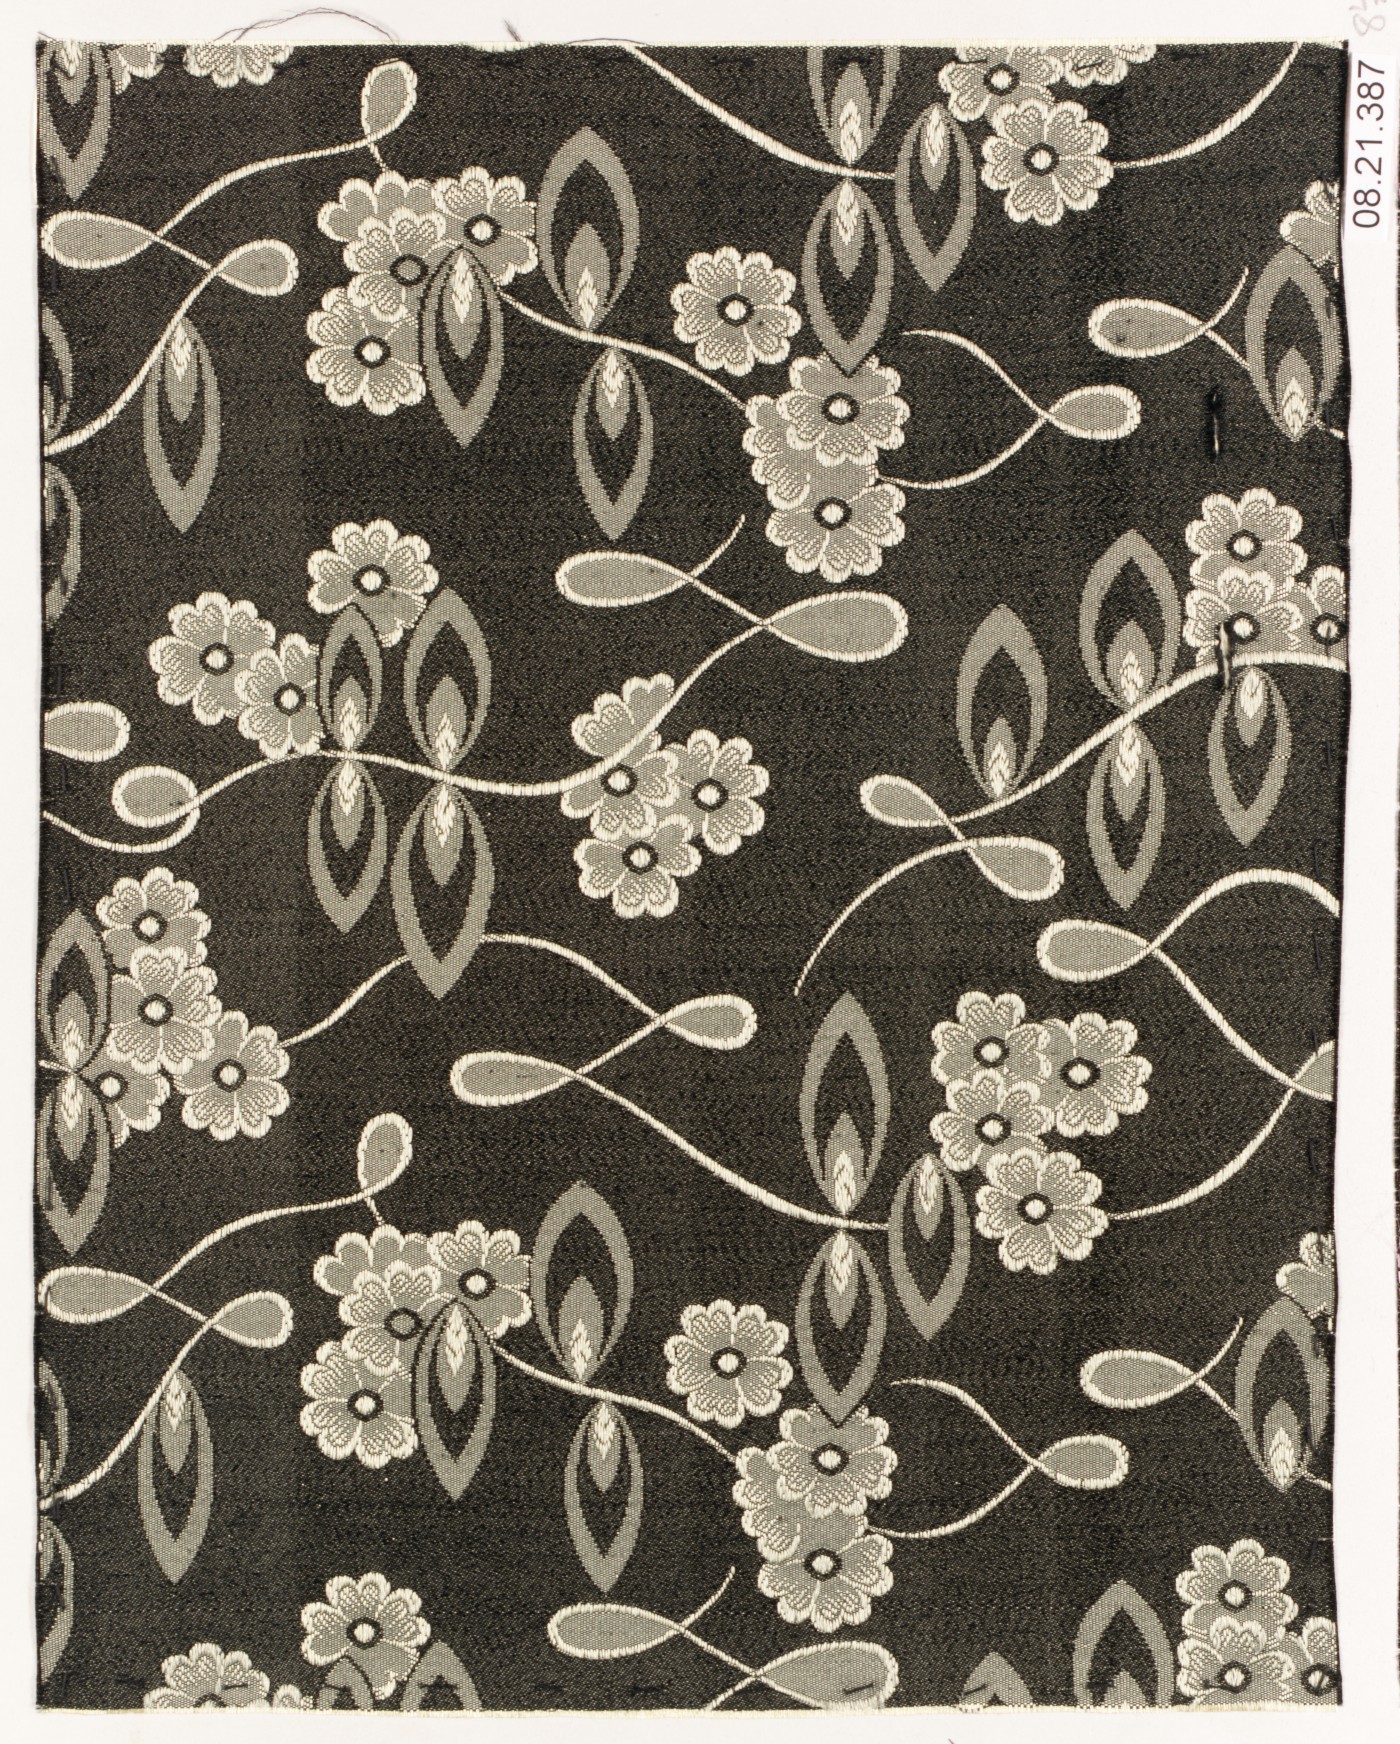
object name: textile sample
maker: Anonymous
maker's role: designer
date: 1900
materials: silk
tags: flowers